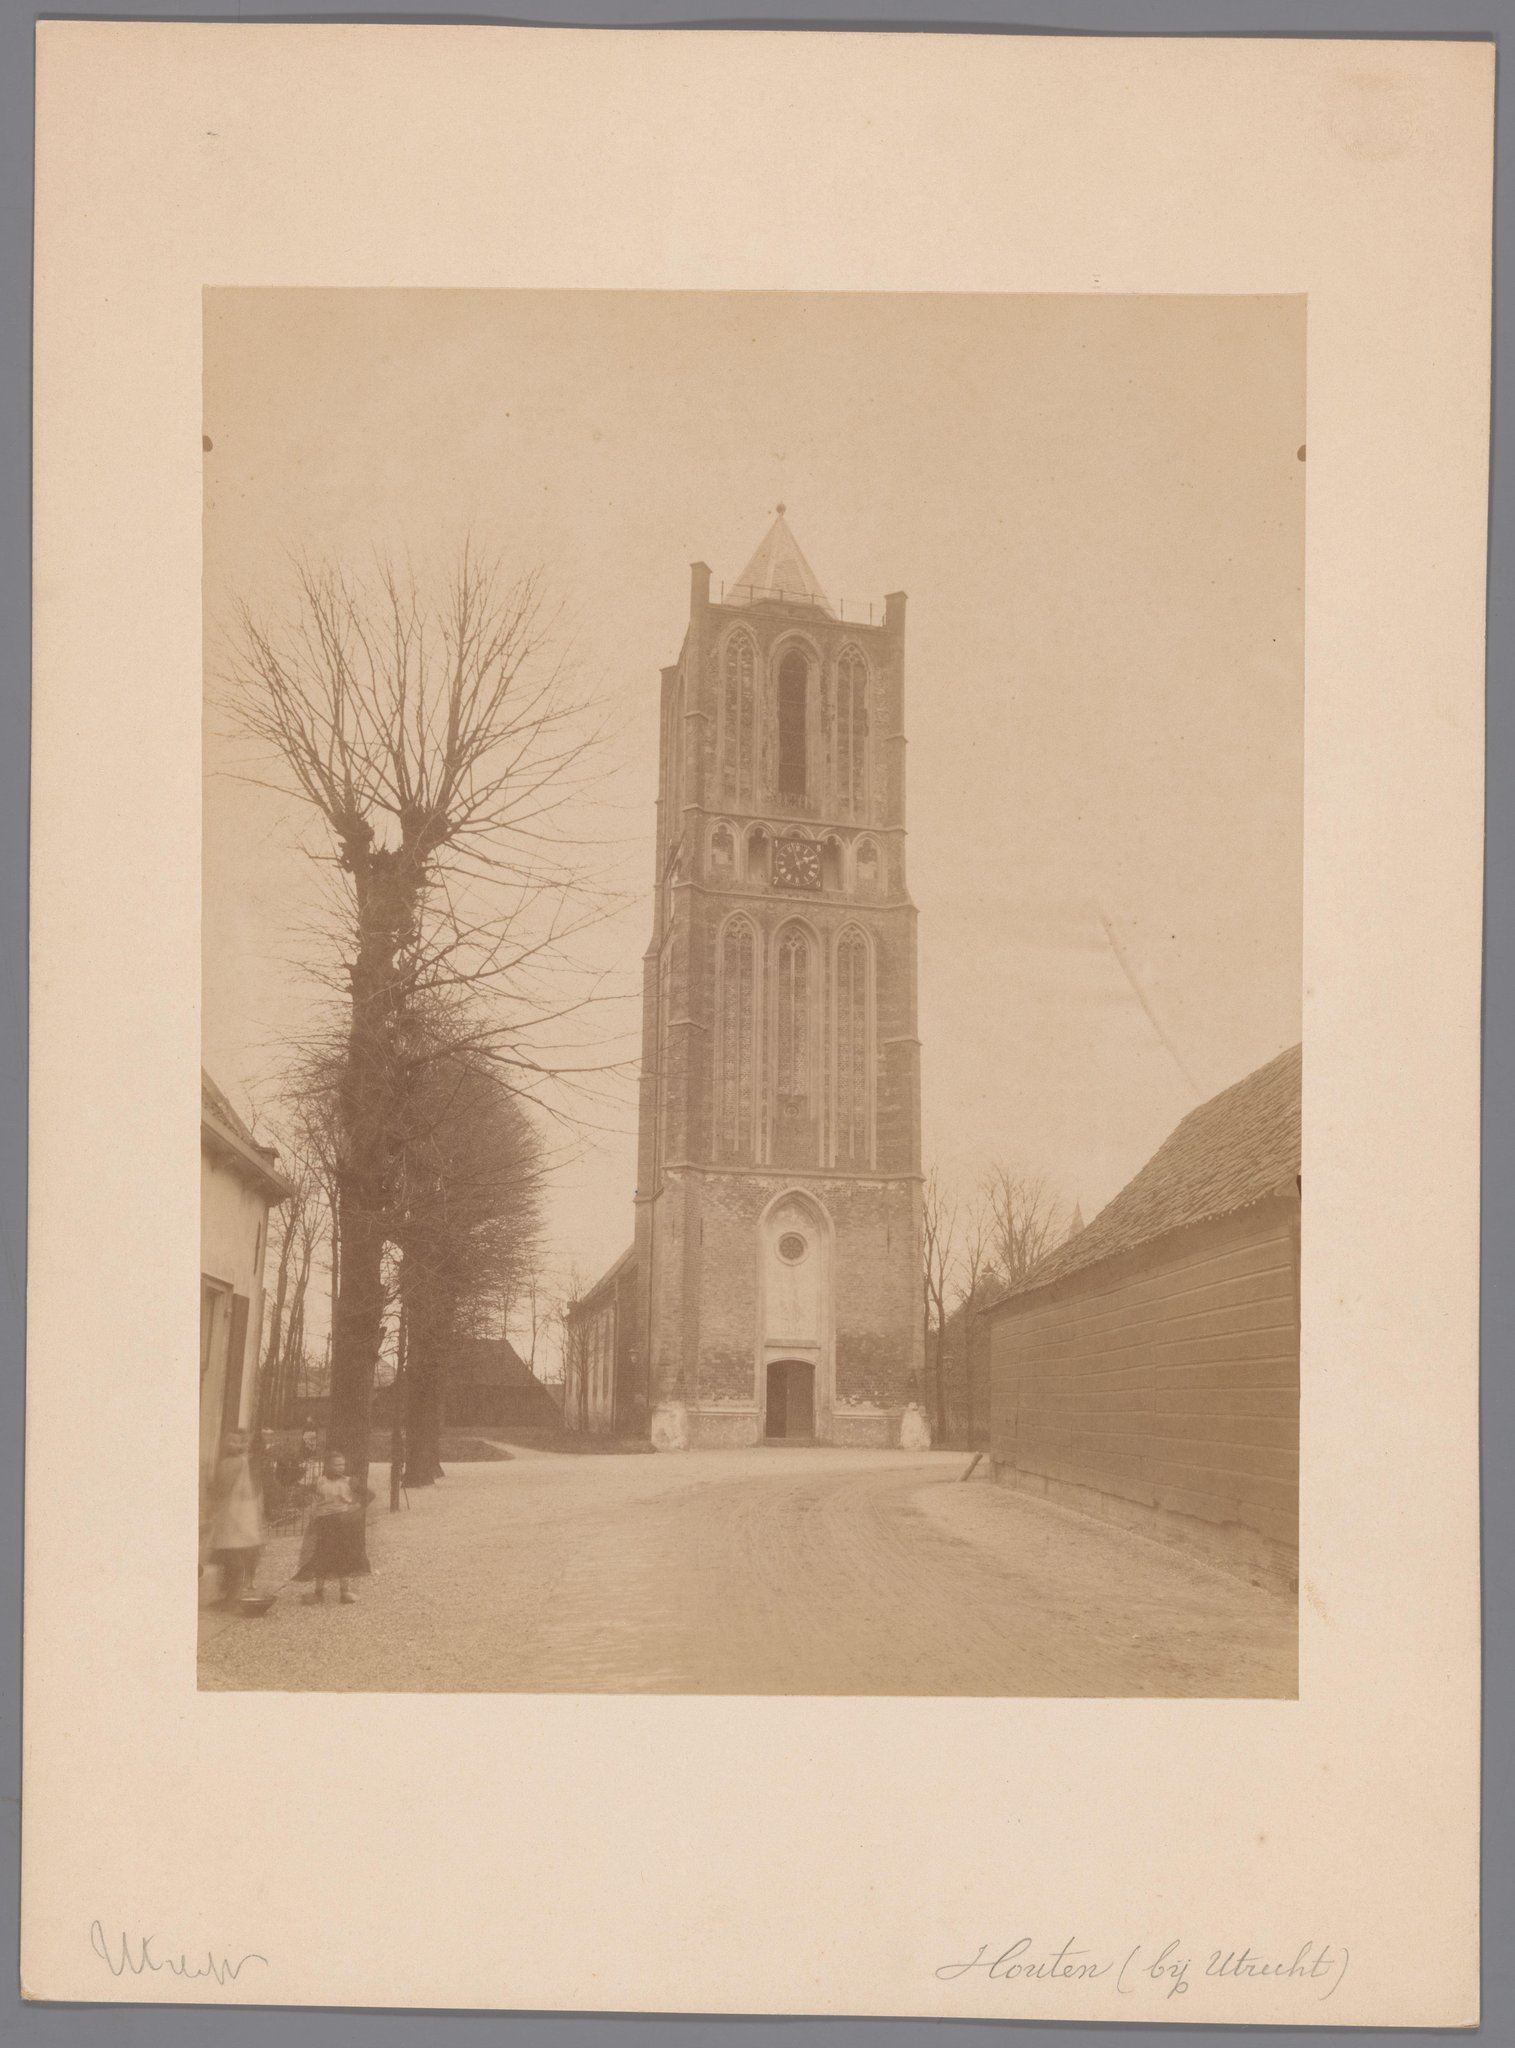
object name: photograph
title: Toren van de Hervormde Kerk te Houten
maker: anoniem (monumentenzorg)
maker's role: fotograaf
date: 1893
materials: cardboard, photographic support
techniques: albumen print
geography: houten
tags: street (+ city(-scape) with figures, staffage), parts of church exterior and annexes: tower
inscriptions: annotation: ‘Toren te Houten bij Utrecht/ Maart 1893’, annotation: ‘Houten (bij Utrecht)’